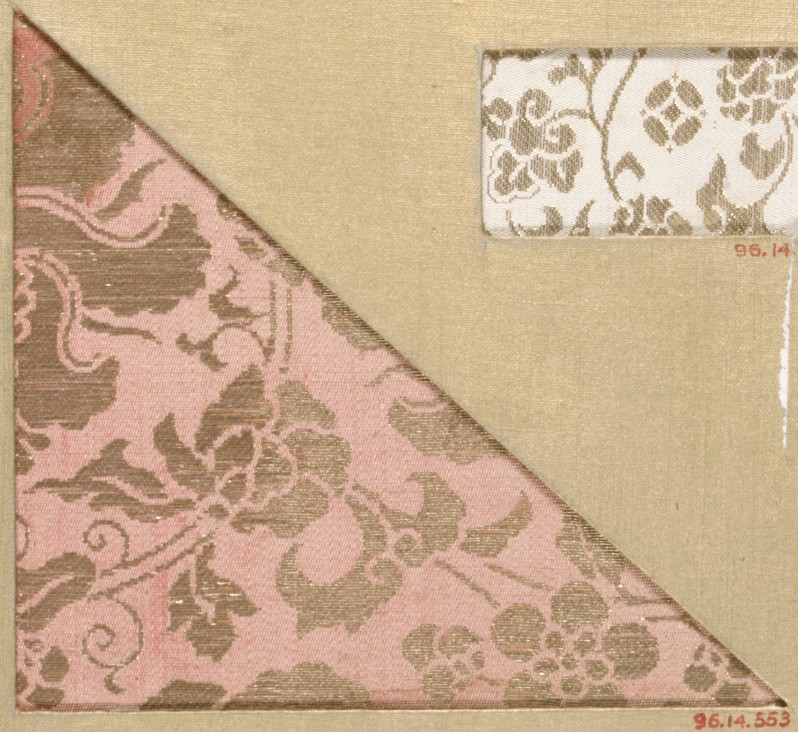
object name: piece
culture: japanese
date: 1701-1900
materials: silk